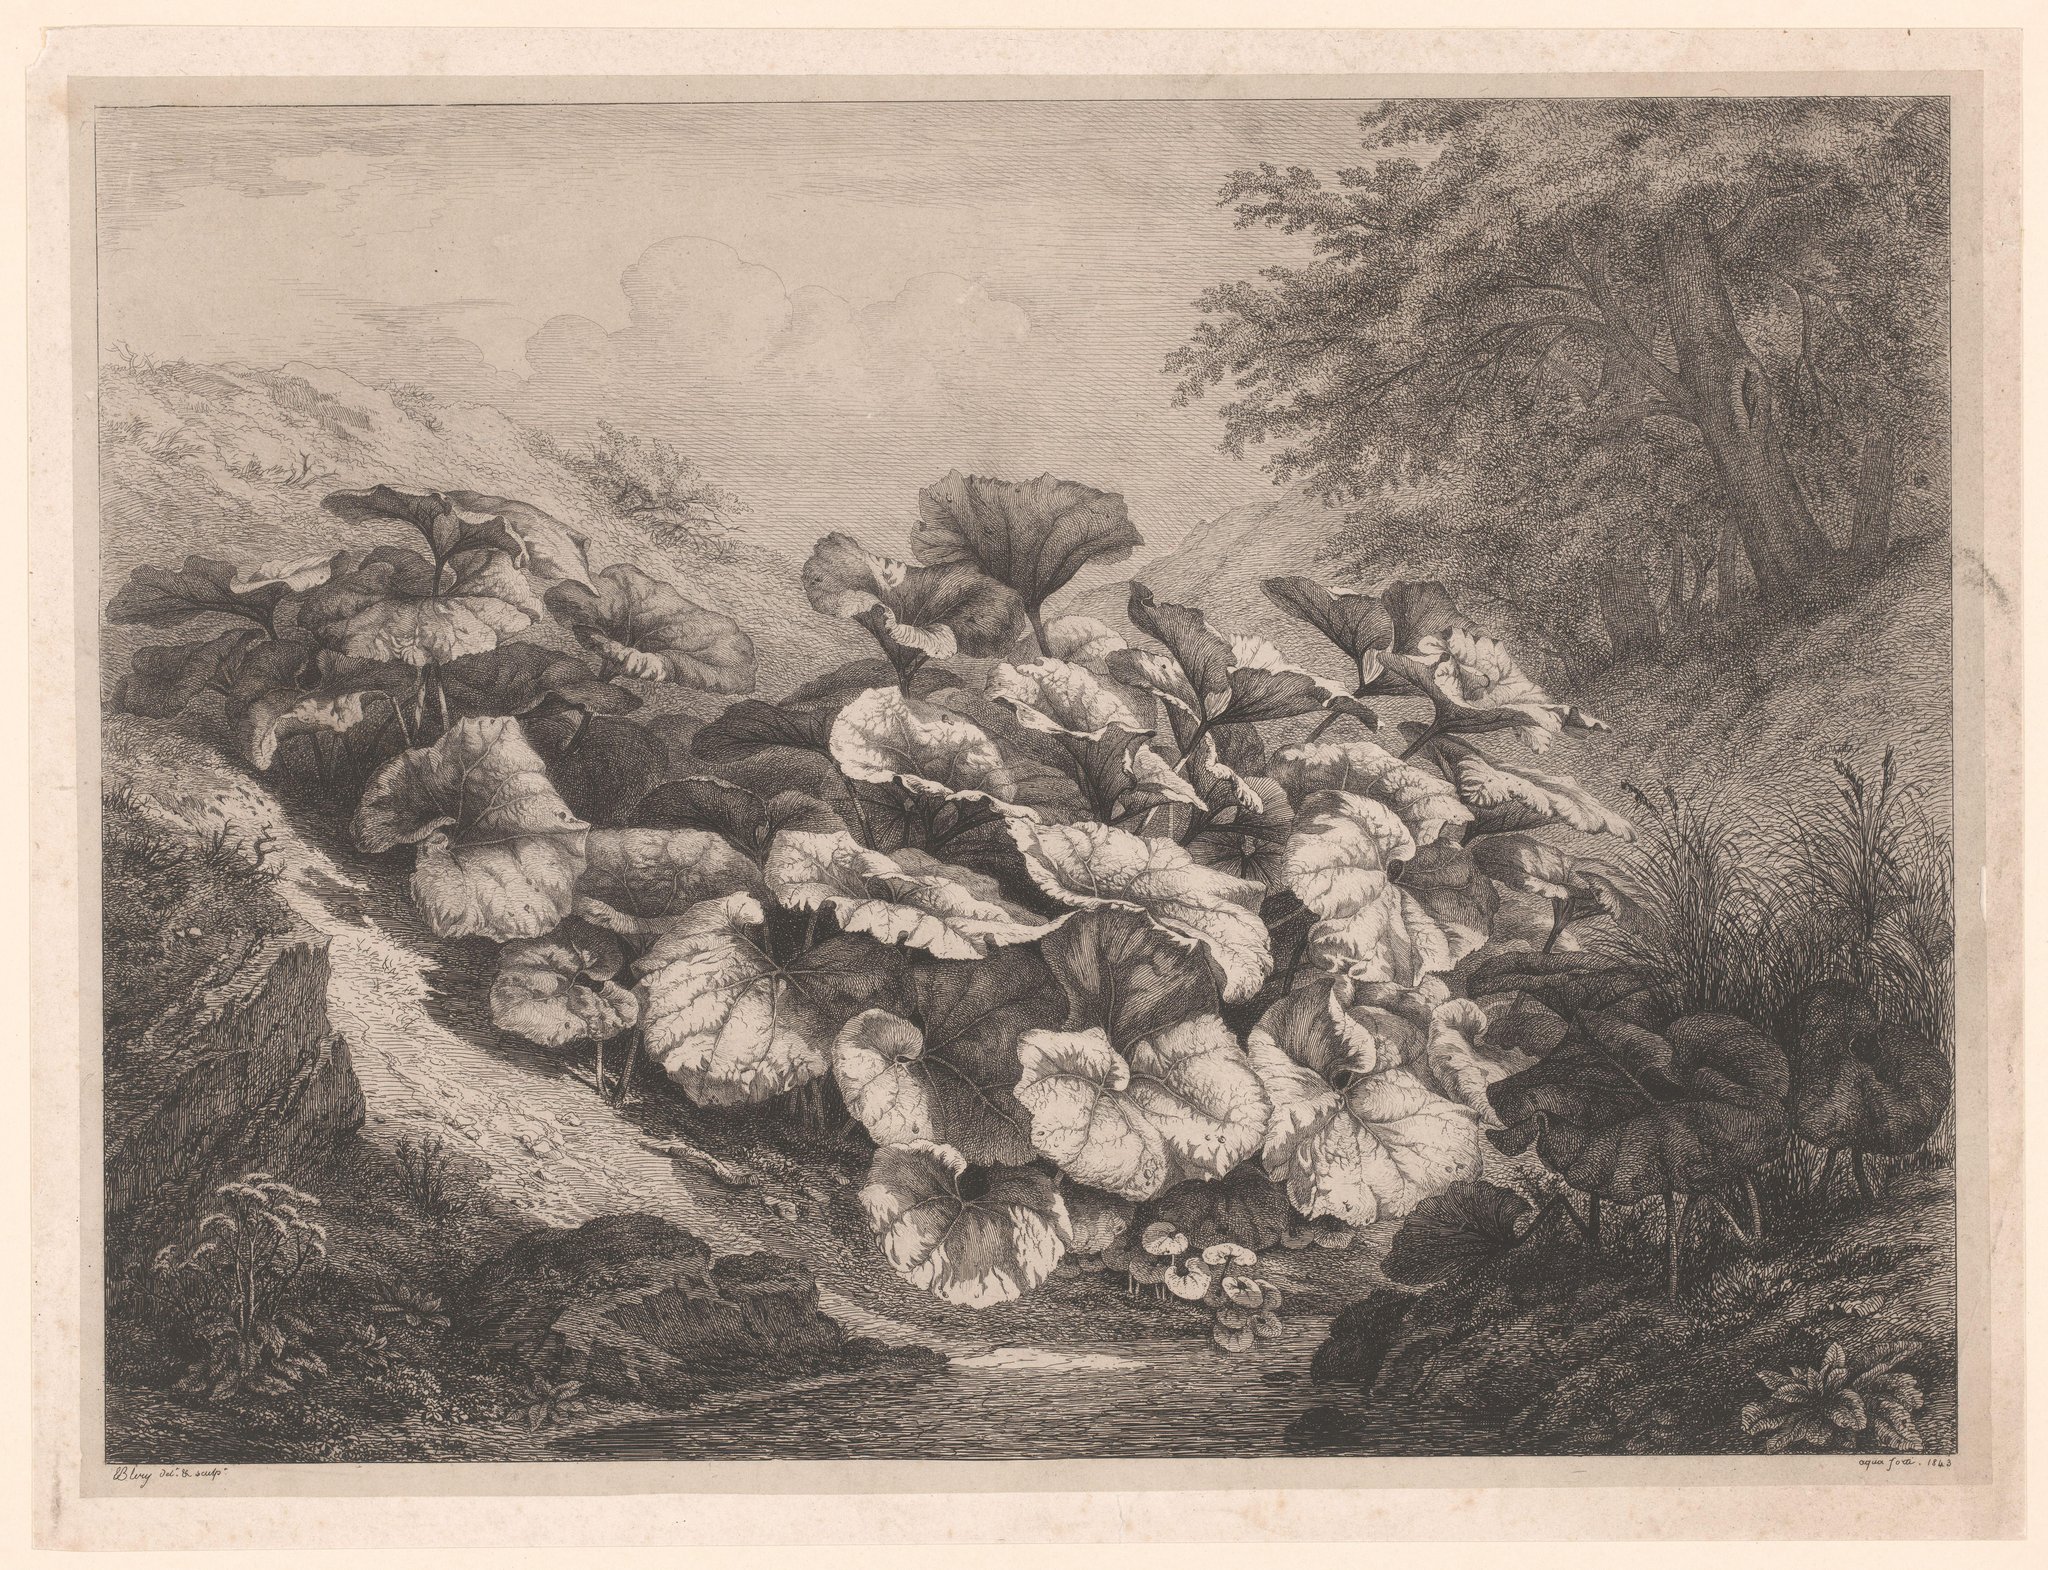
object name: print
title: Les quatre grandes plantes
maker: eugène bléry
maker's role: print maker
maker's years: 1805-1887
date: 1843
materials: paper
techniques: aquatint, drypoint, engraving, etching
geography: france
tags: plants (in general)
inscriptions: collector's mark: Lugt 2228